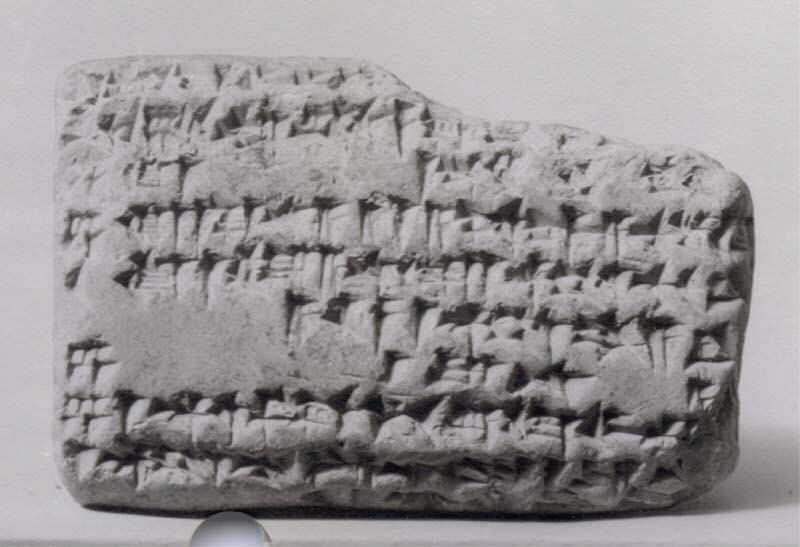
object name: cuneiform tablet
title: Cuneiform tablet: account of barley disbursements to prebendary bakers, Ebabbar archive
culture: babylonian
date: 620 BCE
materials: clay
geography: mesopotamia